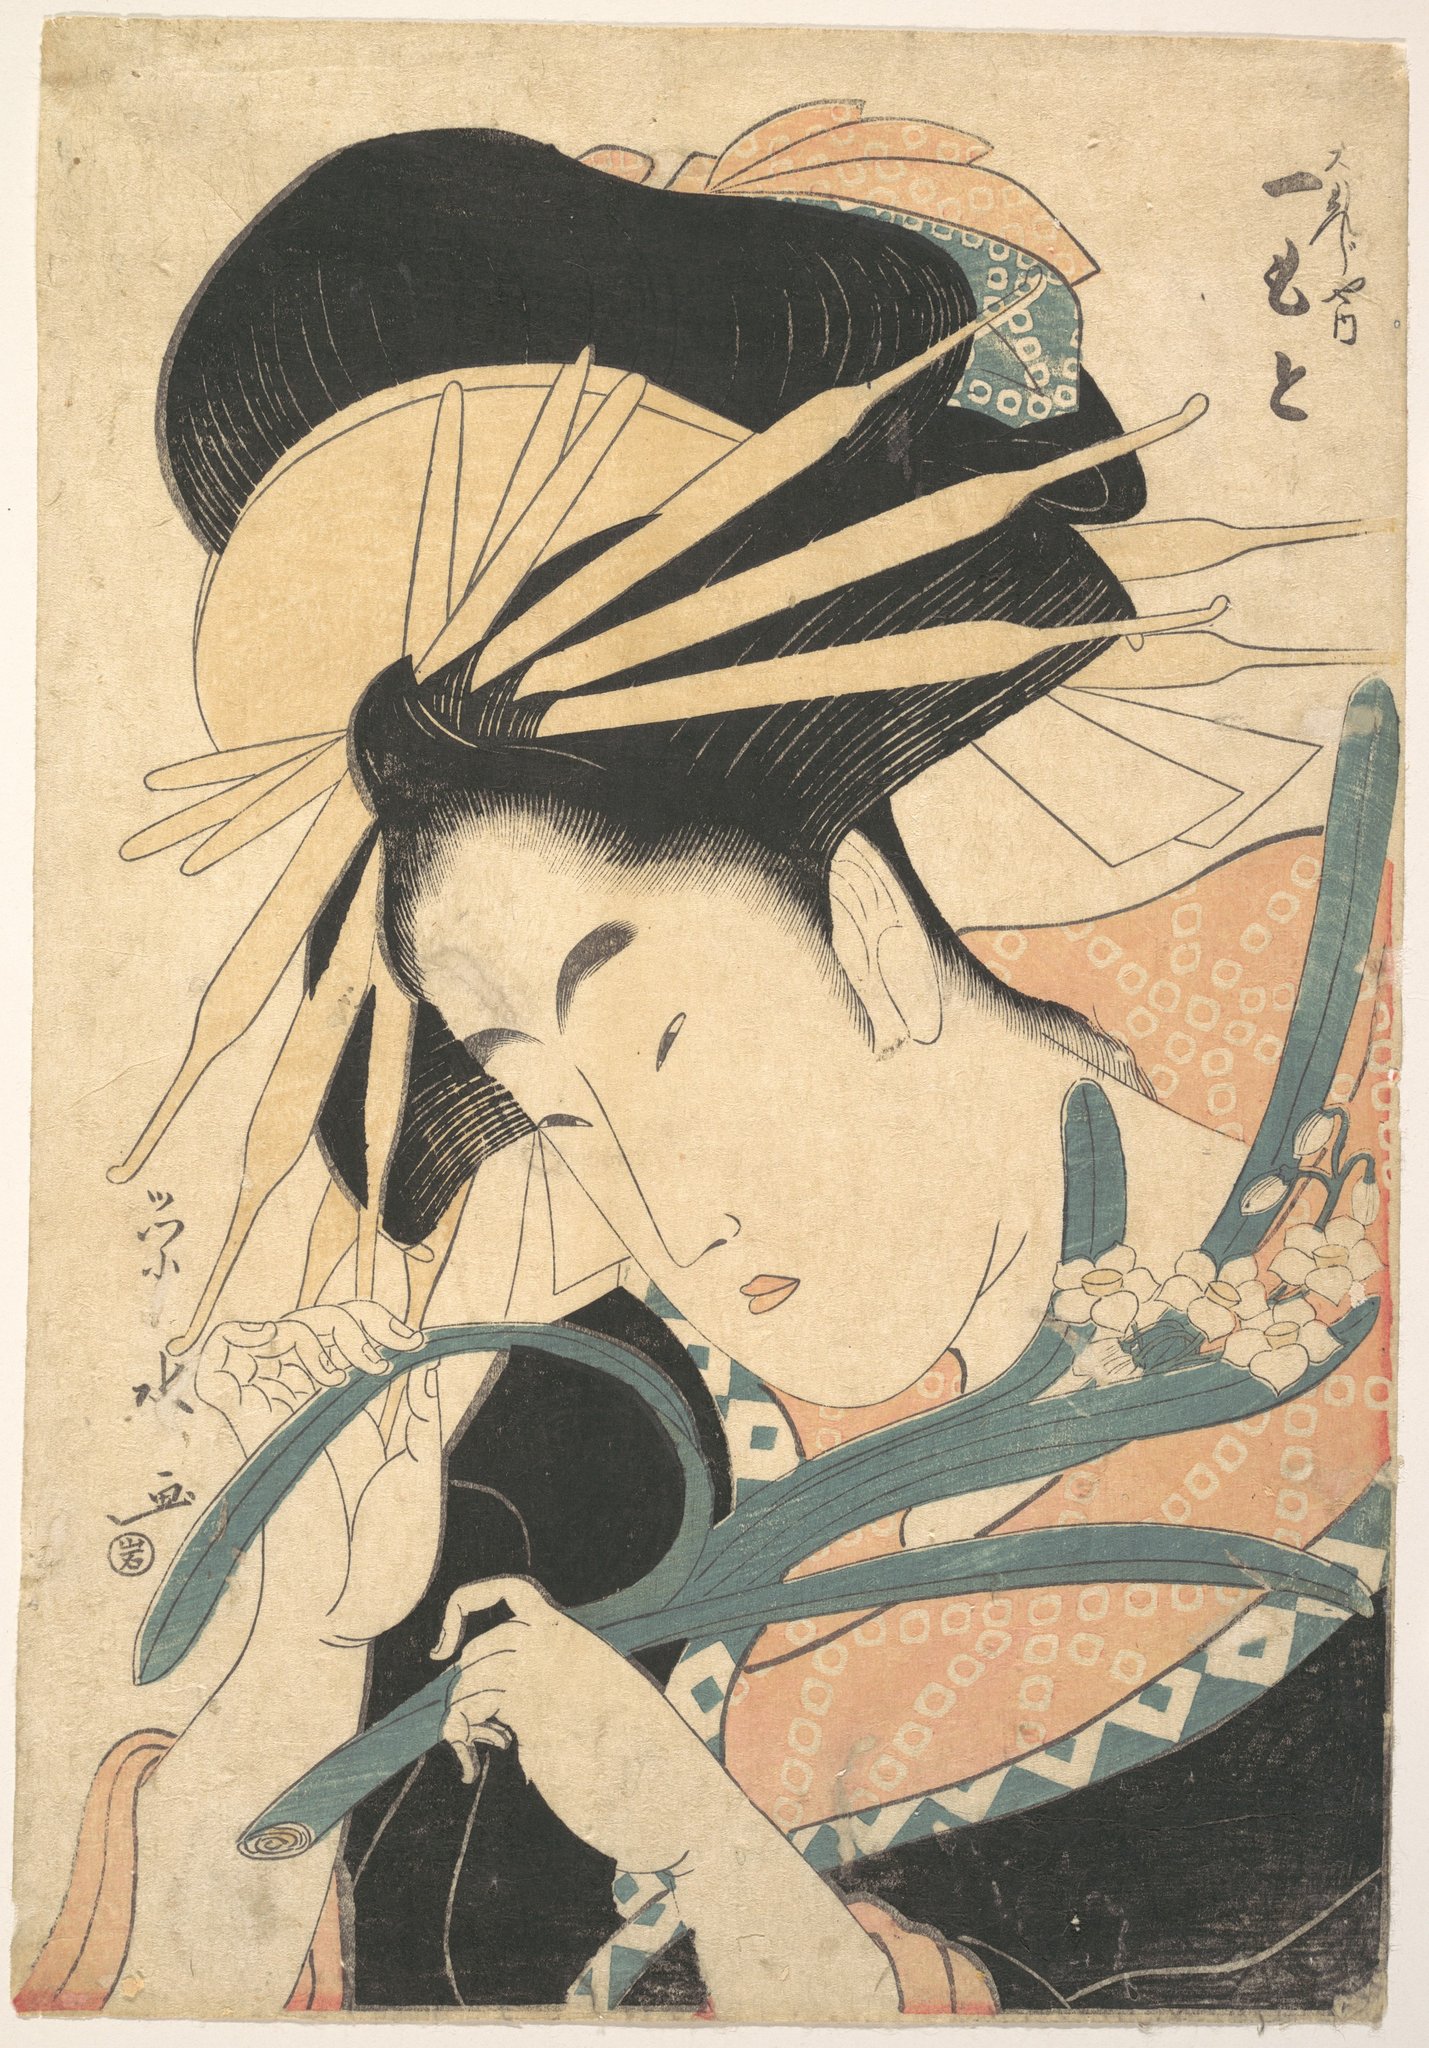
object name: print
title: A Beauty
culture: japanese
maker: ichirakutei eisui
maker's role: artist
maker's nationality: japanese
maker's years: 1793-1801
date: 1793-1801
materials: ink, paper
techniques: woodblock print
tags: women,flowers